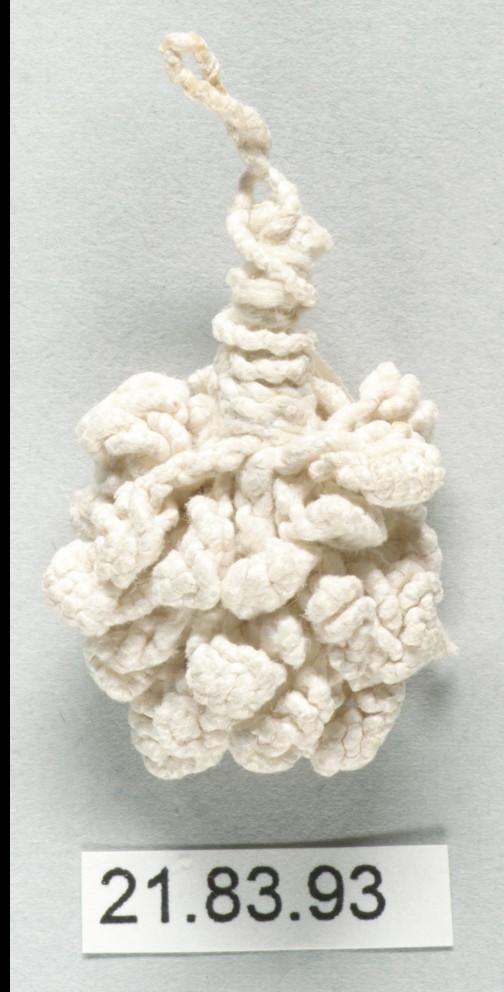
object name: tassel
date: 1601-1700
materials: linen